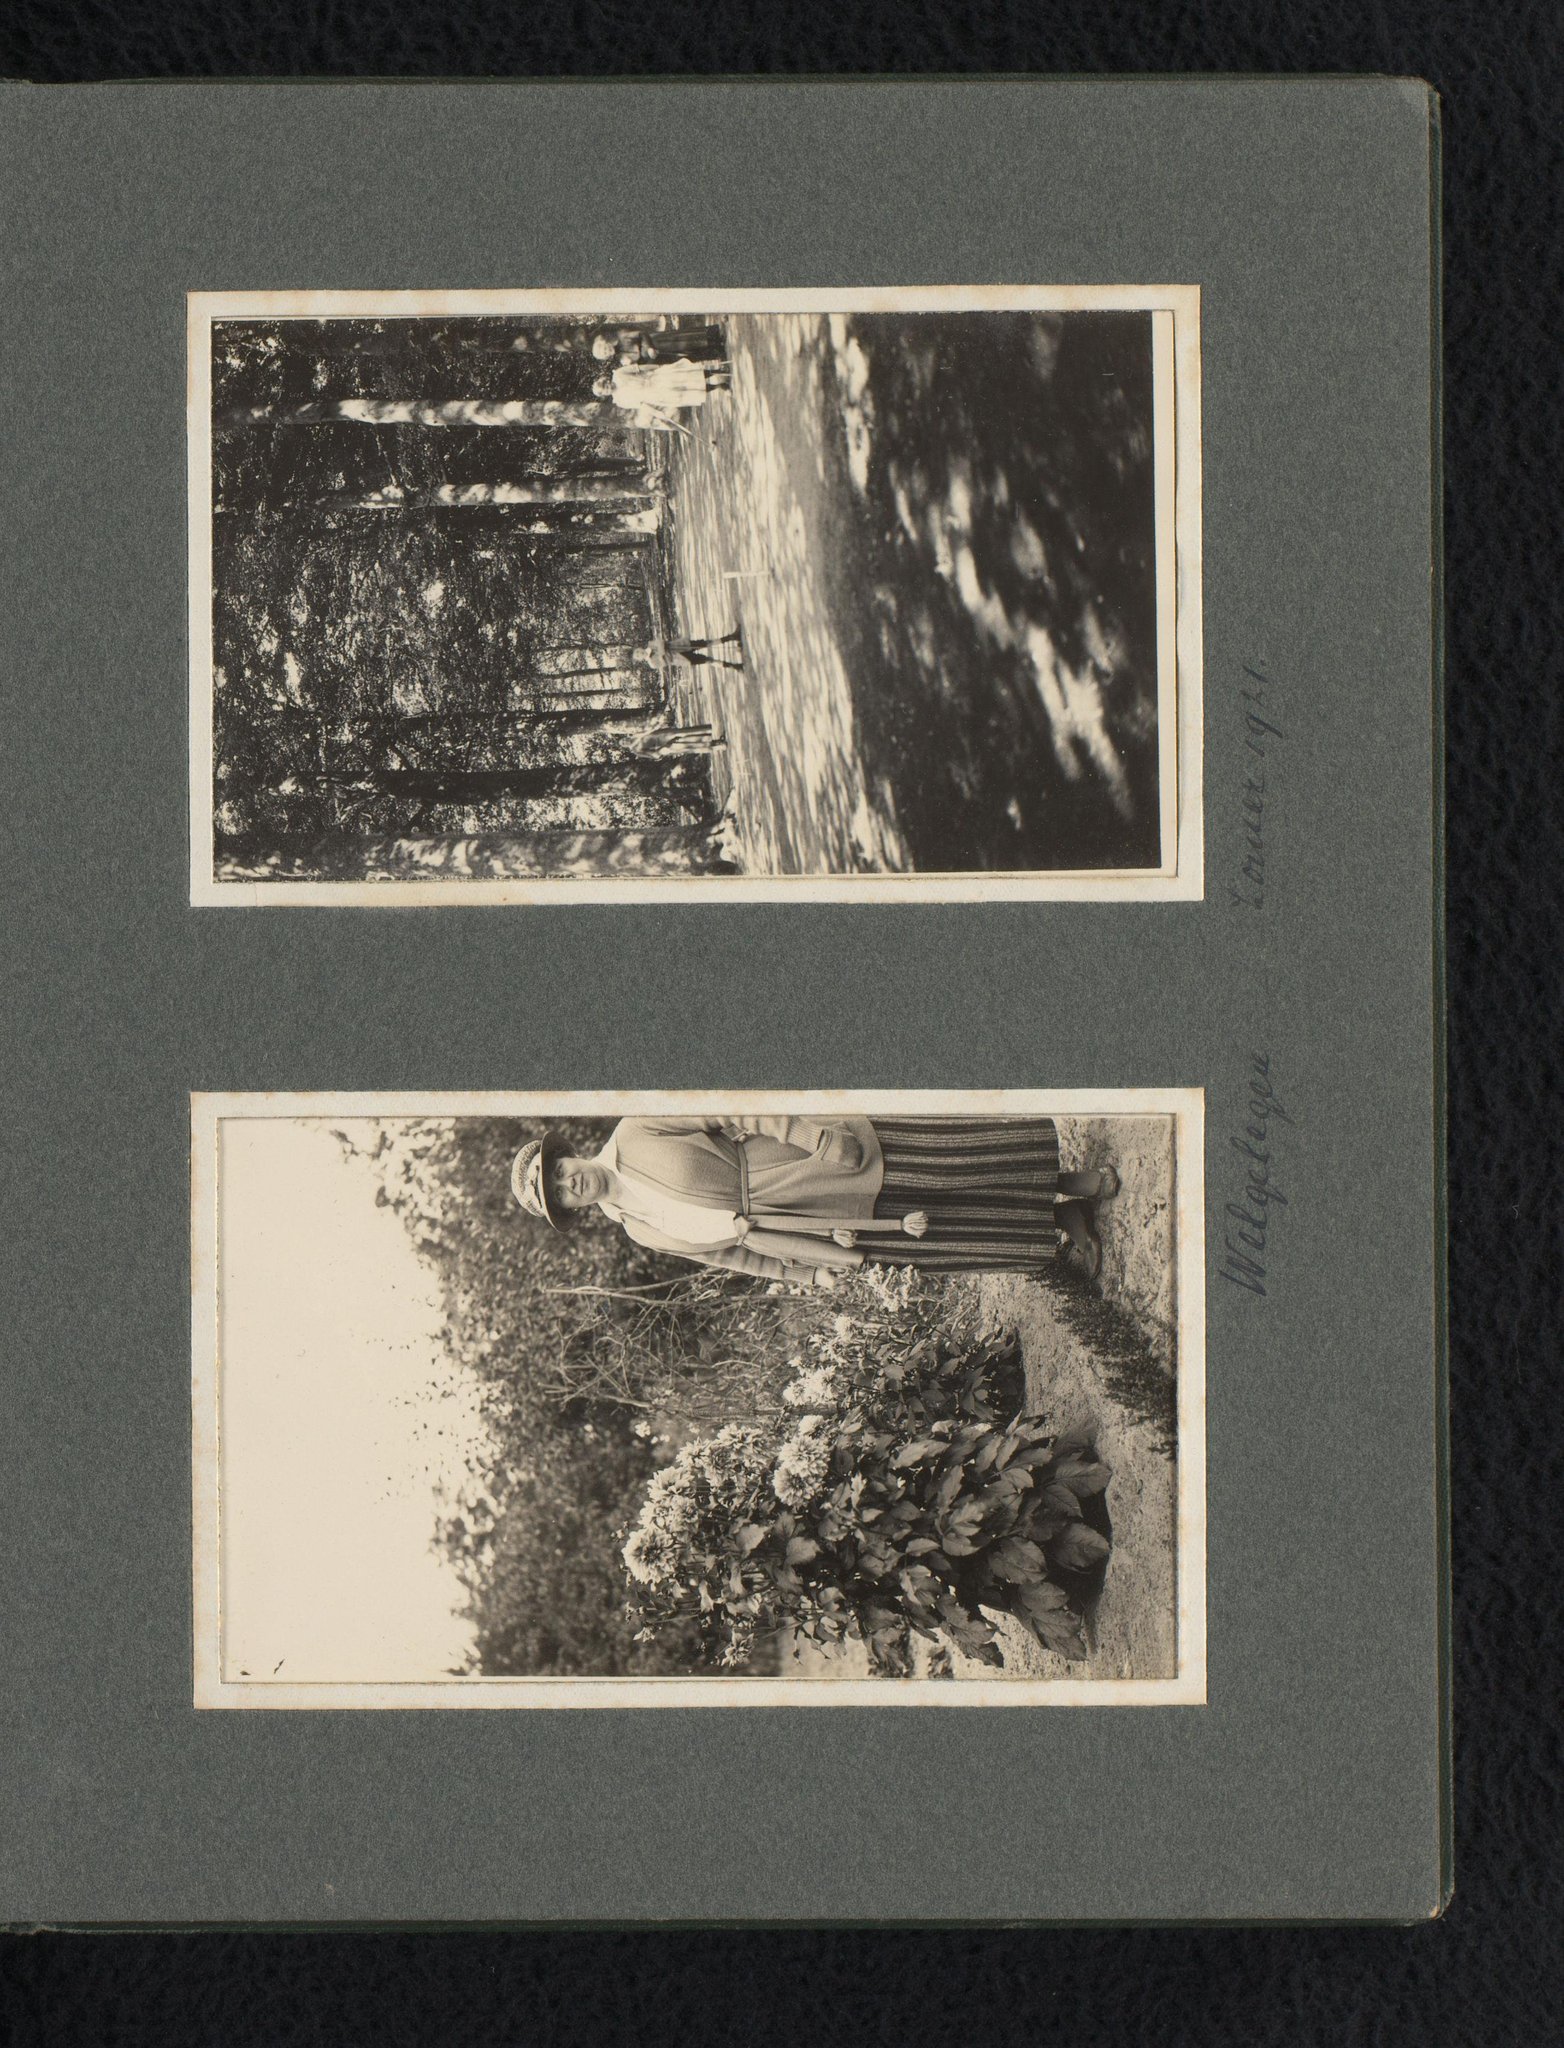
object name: photograph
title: Twee foto's van Caroline van den Berg in de tuin van Huize Welgelegen en familieleden die croquet spelen in het bos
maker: hendrik herman van den berg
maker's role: amateurfotograaf, jurist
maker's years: 1875-1944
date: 1921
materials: paper, cardboard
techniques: gelatin silver print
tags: the hague, caroline louise van den berg-van den berg, historical persons - bb - woman, forest, wood, ball games (children's games)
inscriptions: caption: ‘Welgelegen Zomer 1921’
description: Deze foto's maken deel uit van een album.